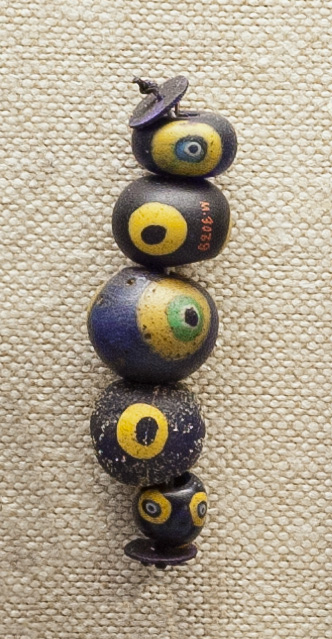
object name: necklace, bead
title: String of 5 Eyed Beads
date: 1101-1200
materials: glass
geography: egypt